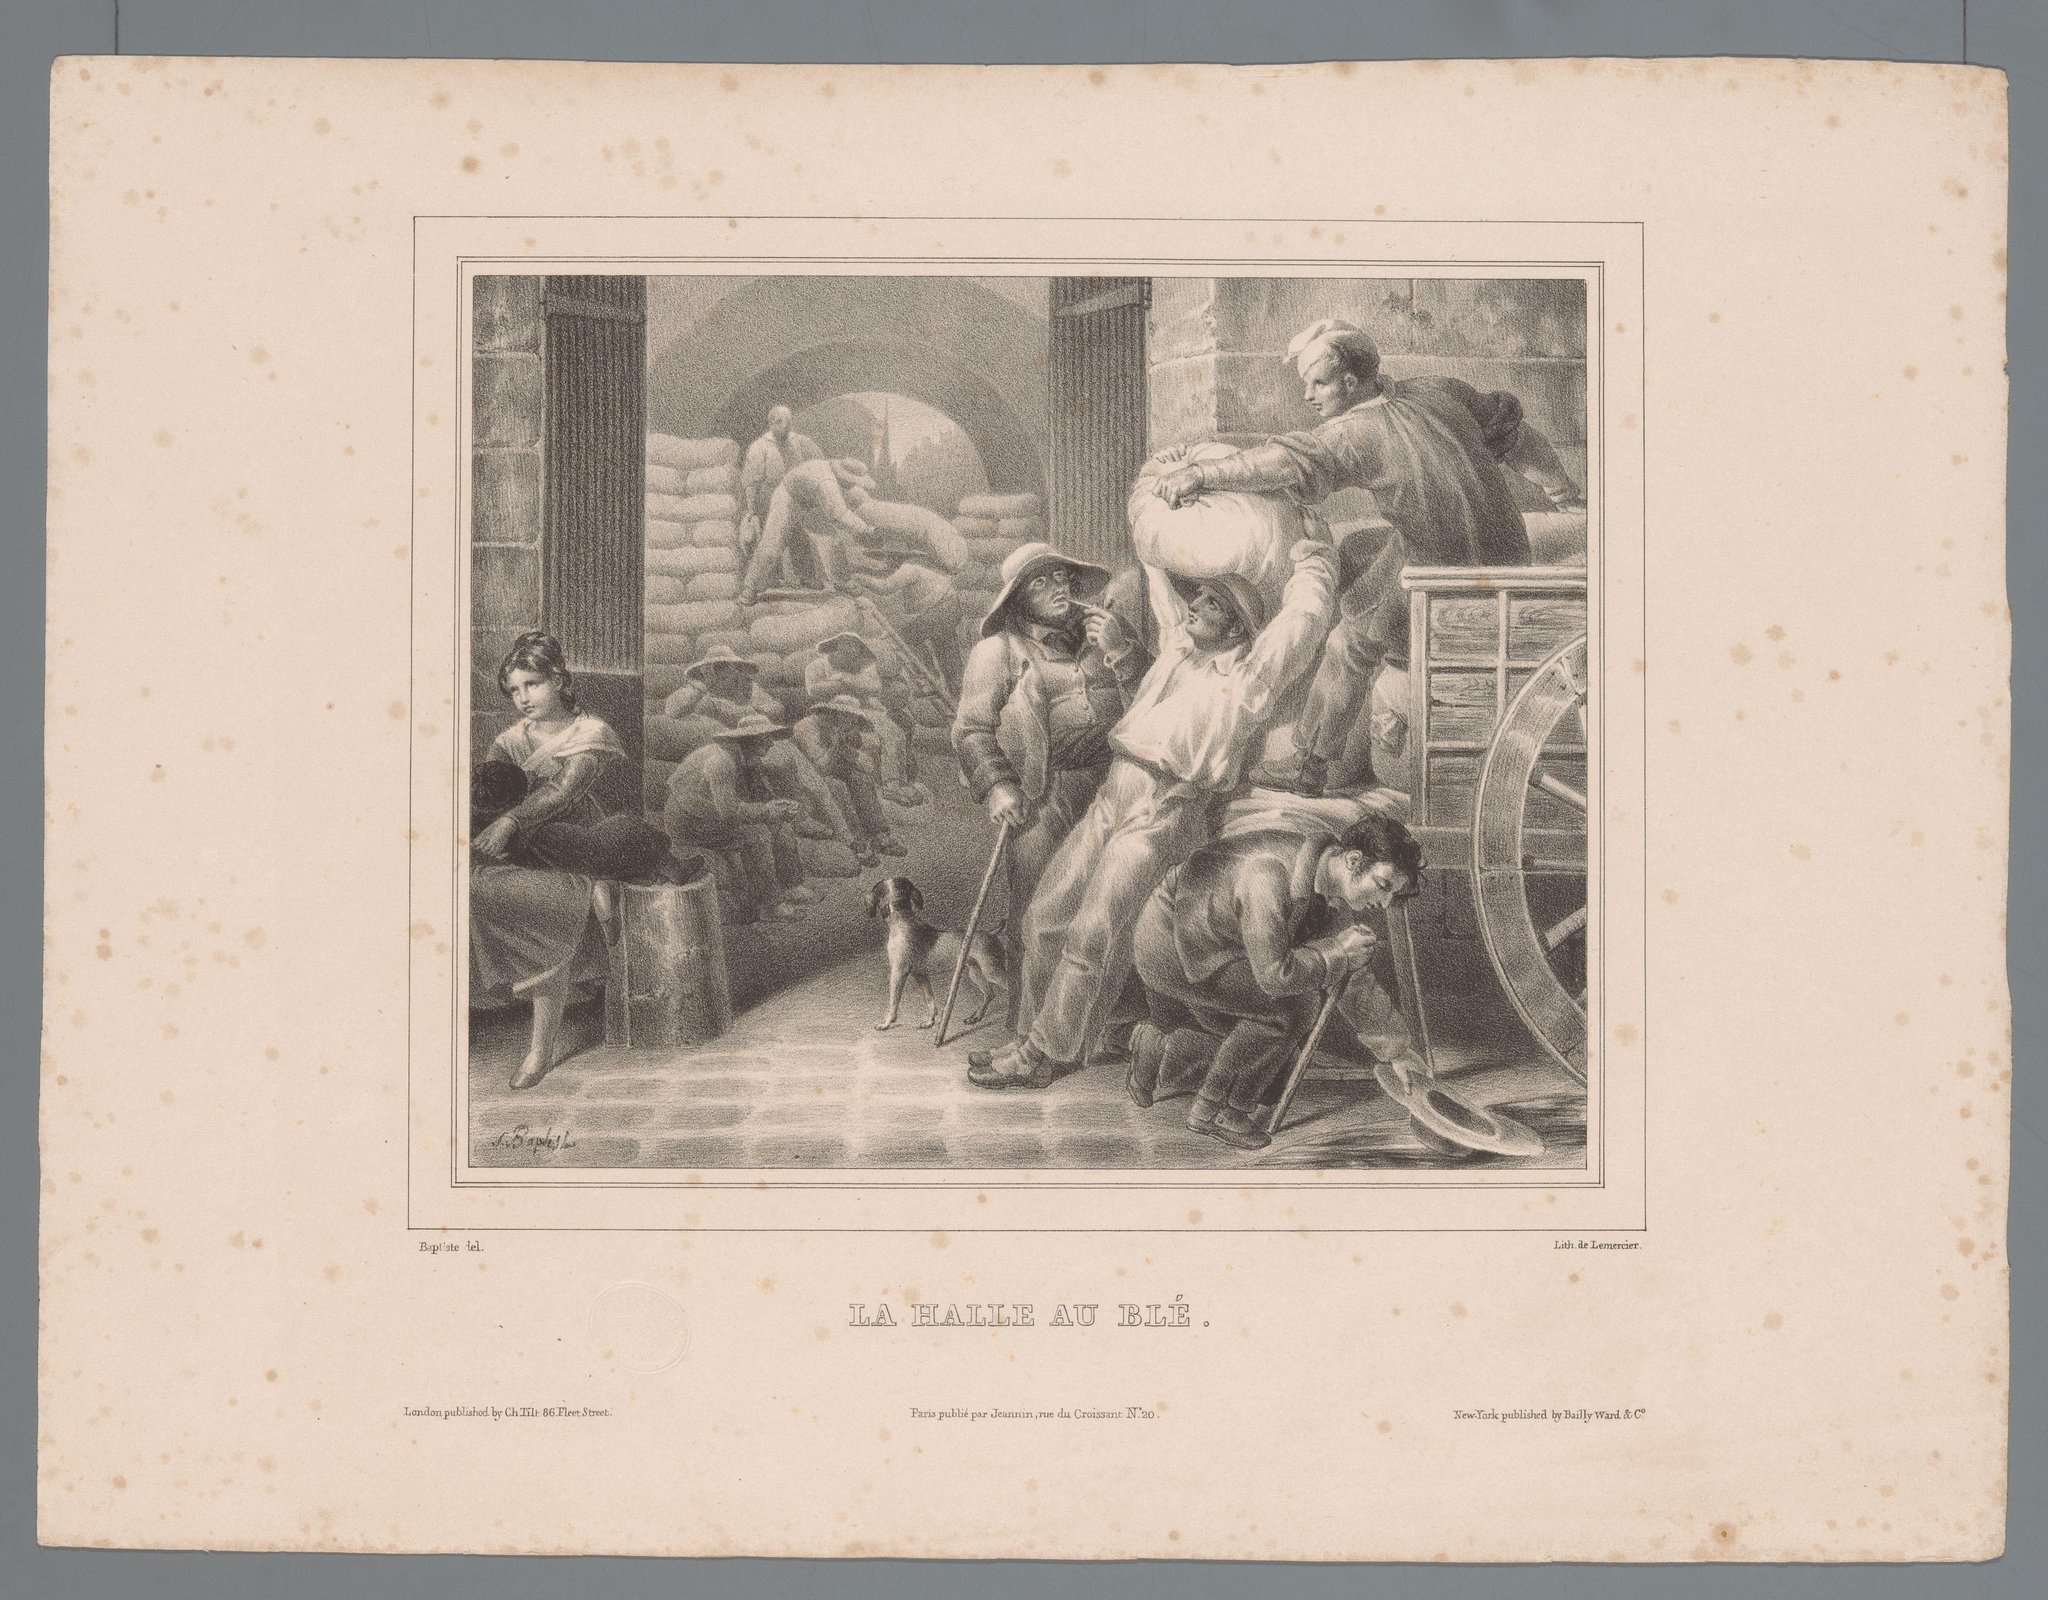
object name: print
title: Arbeiders verplaatsen zakken graan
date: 1833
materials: paper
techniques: lithography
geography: london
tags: cereal, grain, corn (grass with grains, grown for food, e.g.: wheat, rice, rye, oats, maize, buckwheat, millet) (+ labourers ~ crafts, industries, agriculture), cereal, grain, corn (grass with grains, grown for food, e.g.: wheat, rice, rye, oats, maize, buckwheat, millet) (+ indoors; in laboratory, factory, barn, etc.), market-hall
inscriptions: collector's mark: Lugt 2228a, check stamp: Lugt 3987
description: Deze prent maakt deel uit van een omslag met zes prenten.